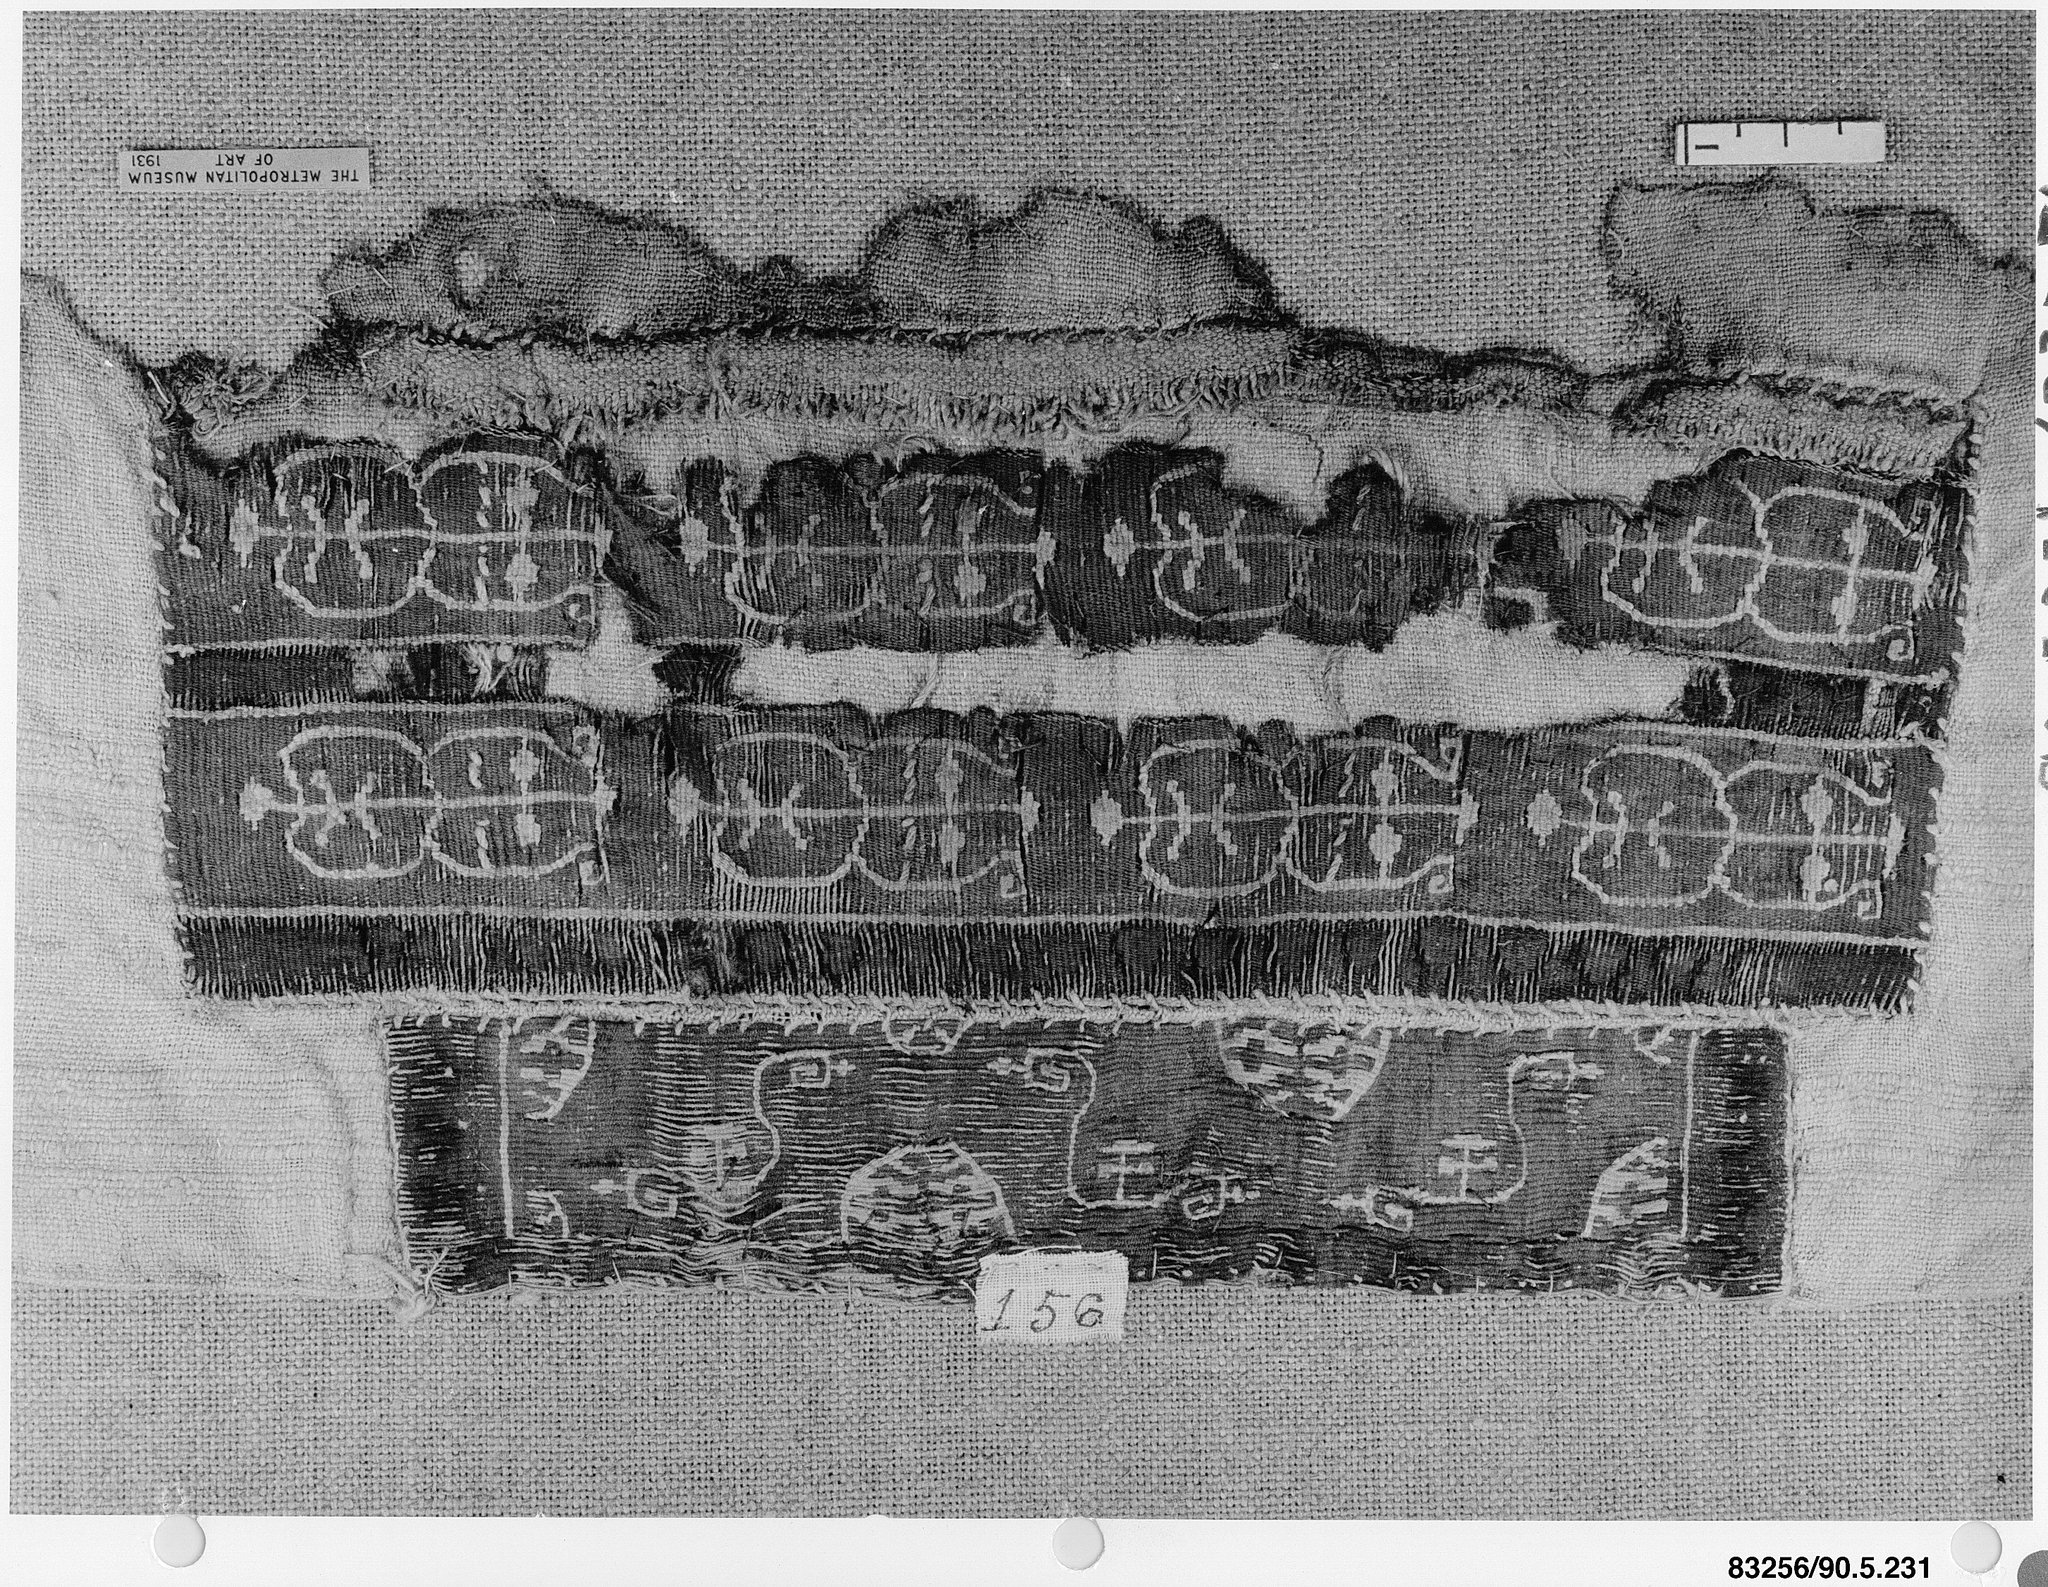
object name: textile fragment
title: Fragment of a Sleeve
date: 401-500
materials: linen, wool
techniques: weave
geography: egypt